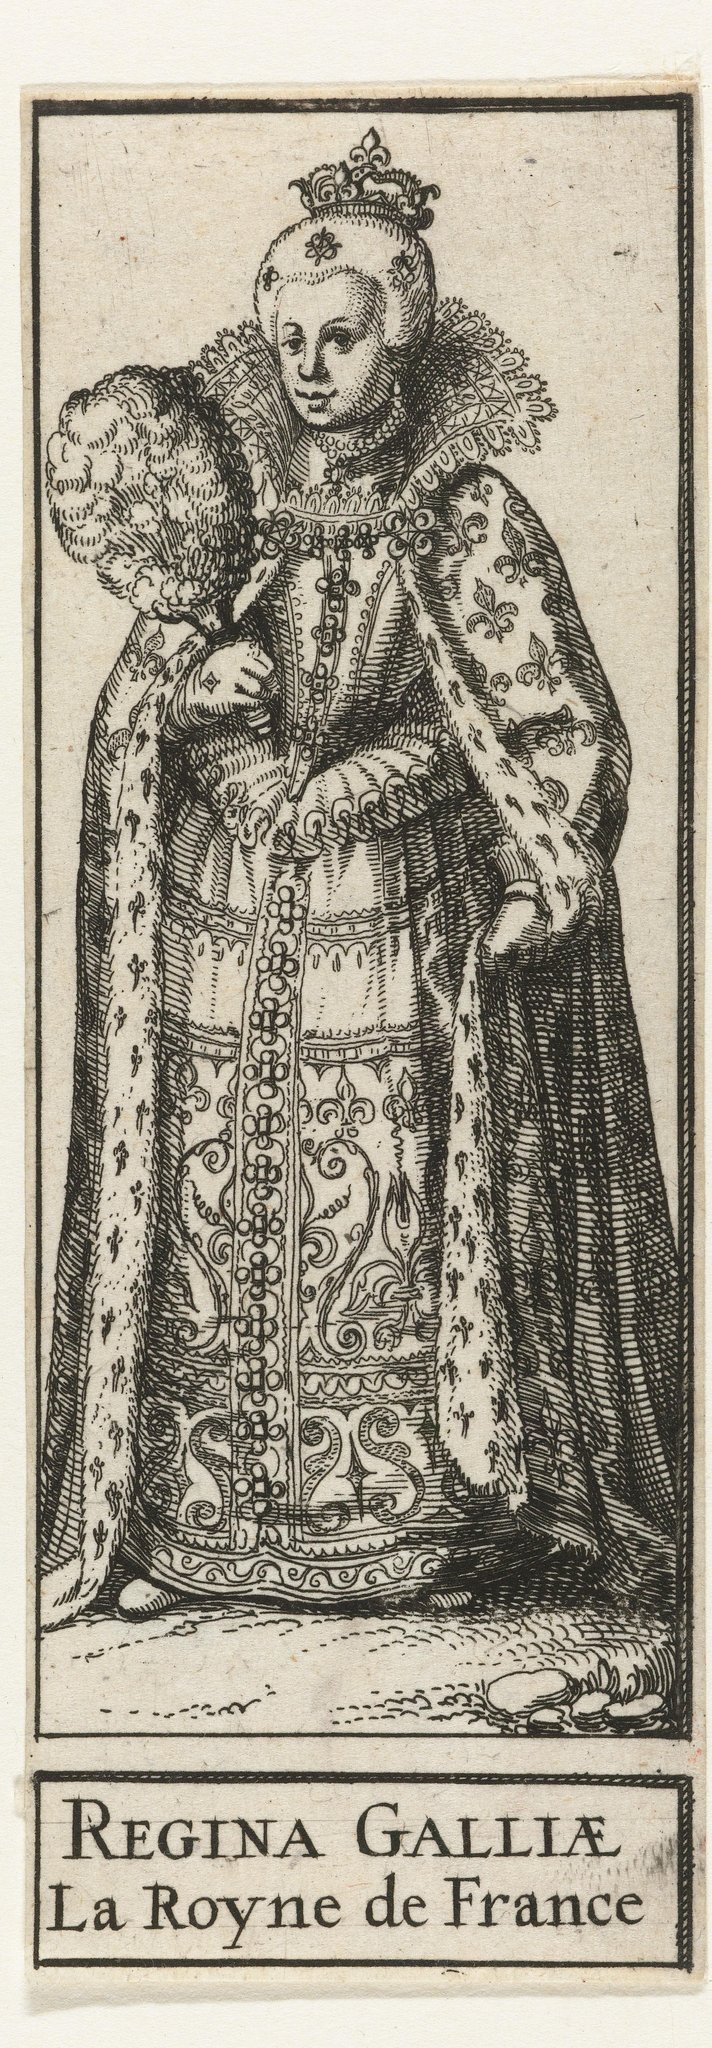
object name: costume print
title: REGINA GALLIAE / La Royne de France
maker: claes jansz. visscher (ii)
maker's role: draughtsman, print maker, publisher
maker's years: 1586-1652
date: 1618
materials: paper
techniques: etching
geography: amsterdam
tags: paris, anna van oostenrijk (koningin van frankrijk), europeans (frenchmen) (+ women), queen, empress, etc. (wife of a ruler), clothes, costume (+ women's clothes), fan (+ women's clothes)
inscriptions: collector's mark: Lugt 1838, caption: ‘REGINA GALLIAE / La Royne de France’, collector's mark: Lugt 240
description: REGINA GALLIAE / La Royne de France: koningin van Frankrijk, gekleed in hermelijnen mantel, waaier in de rechterhand. Onderdeel van rand om kaart met Parijs in vogelvlucht, van twee platen. In de rand links en rechts kostuumprentjes met de vier rangen en standen. Links kostuumprentjes met herenkostuums; rechts de dameskostuums. In RPK alleen de kostuumprentjes los aanwezig.